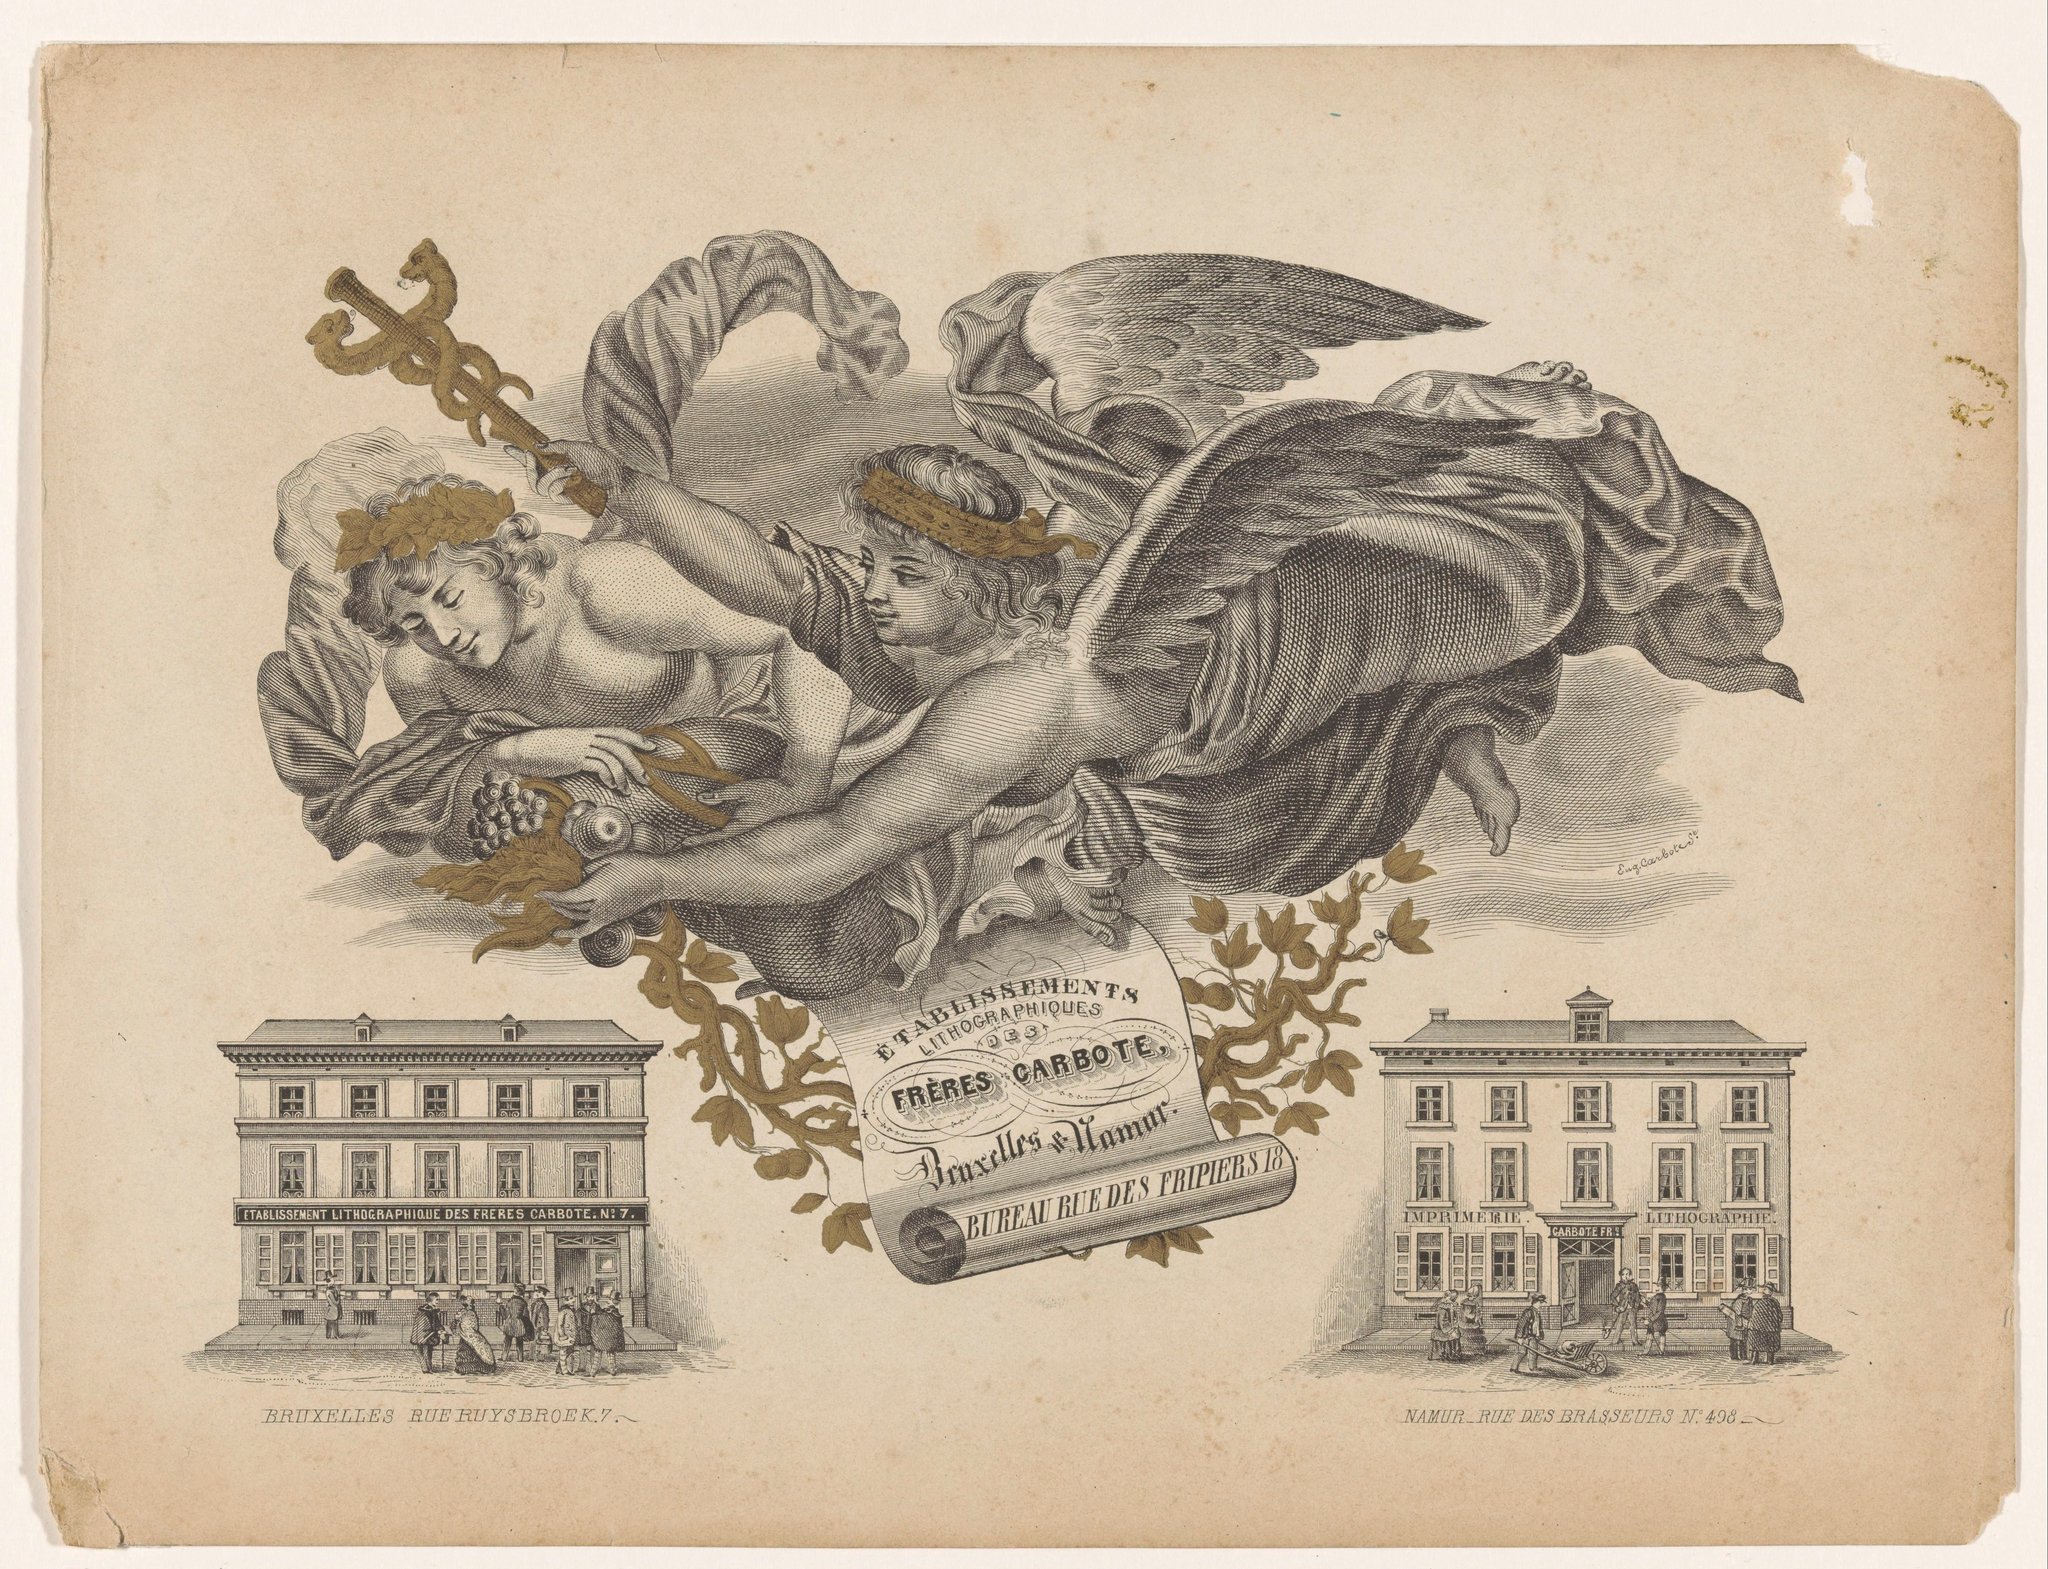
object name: advertising card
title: Reclamekaart voor lithografische drukkerij Frères Carbote te Brussel en Namen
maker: eug. carbote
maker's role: print maker, printer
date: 1825-1875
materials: paper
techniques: lithograph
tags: 'cornucopia', horn of plenty, specific aspects, allegorical aspects of mercury; mercury as patron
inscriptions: collector's mark: Lugt 2228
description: In de lucht vliegt Mercurius, de caduceus in zijn hand, naast hem Overvloed met een krans en de Hoorn des overvloeds. Daaronder de winkels van de gebroeders Carbote in Brussel en Namen.